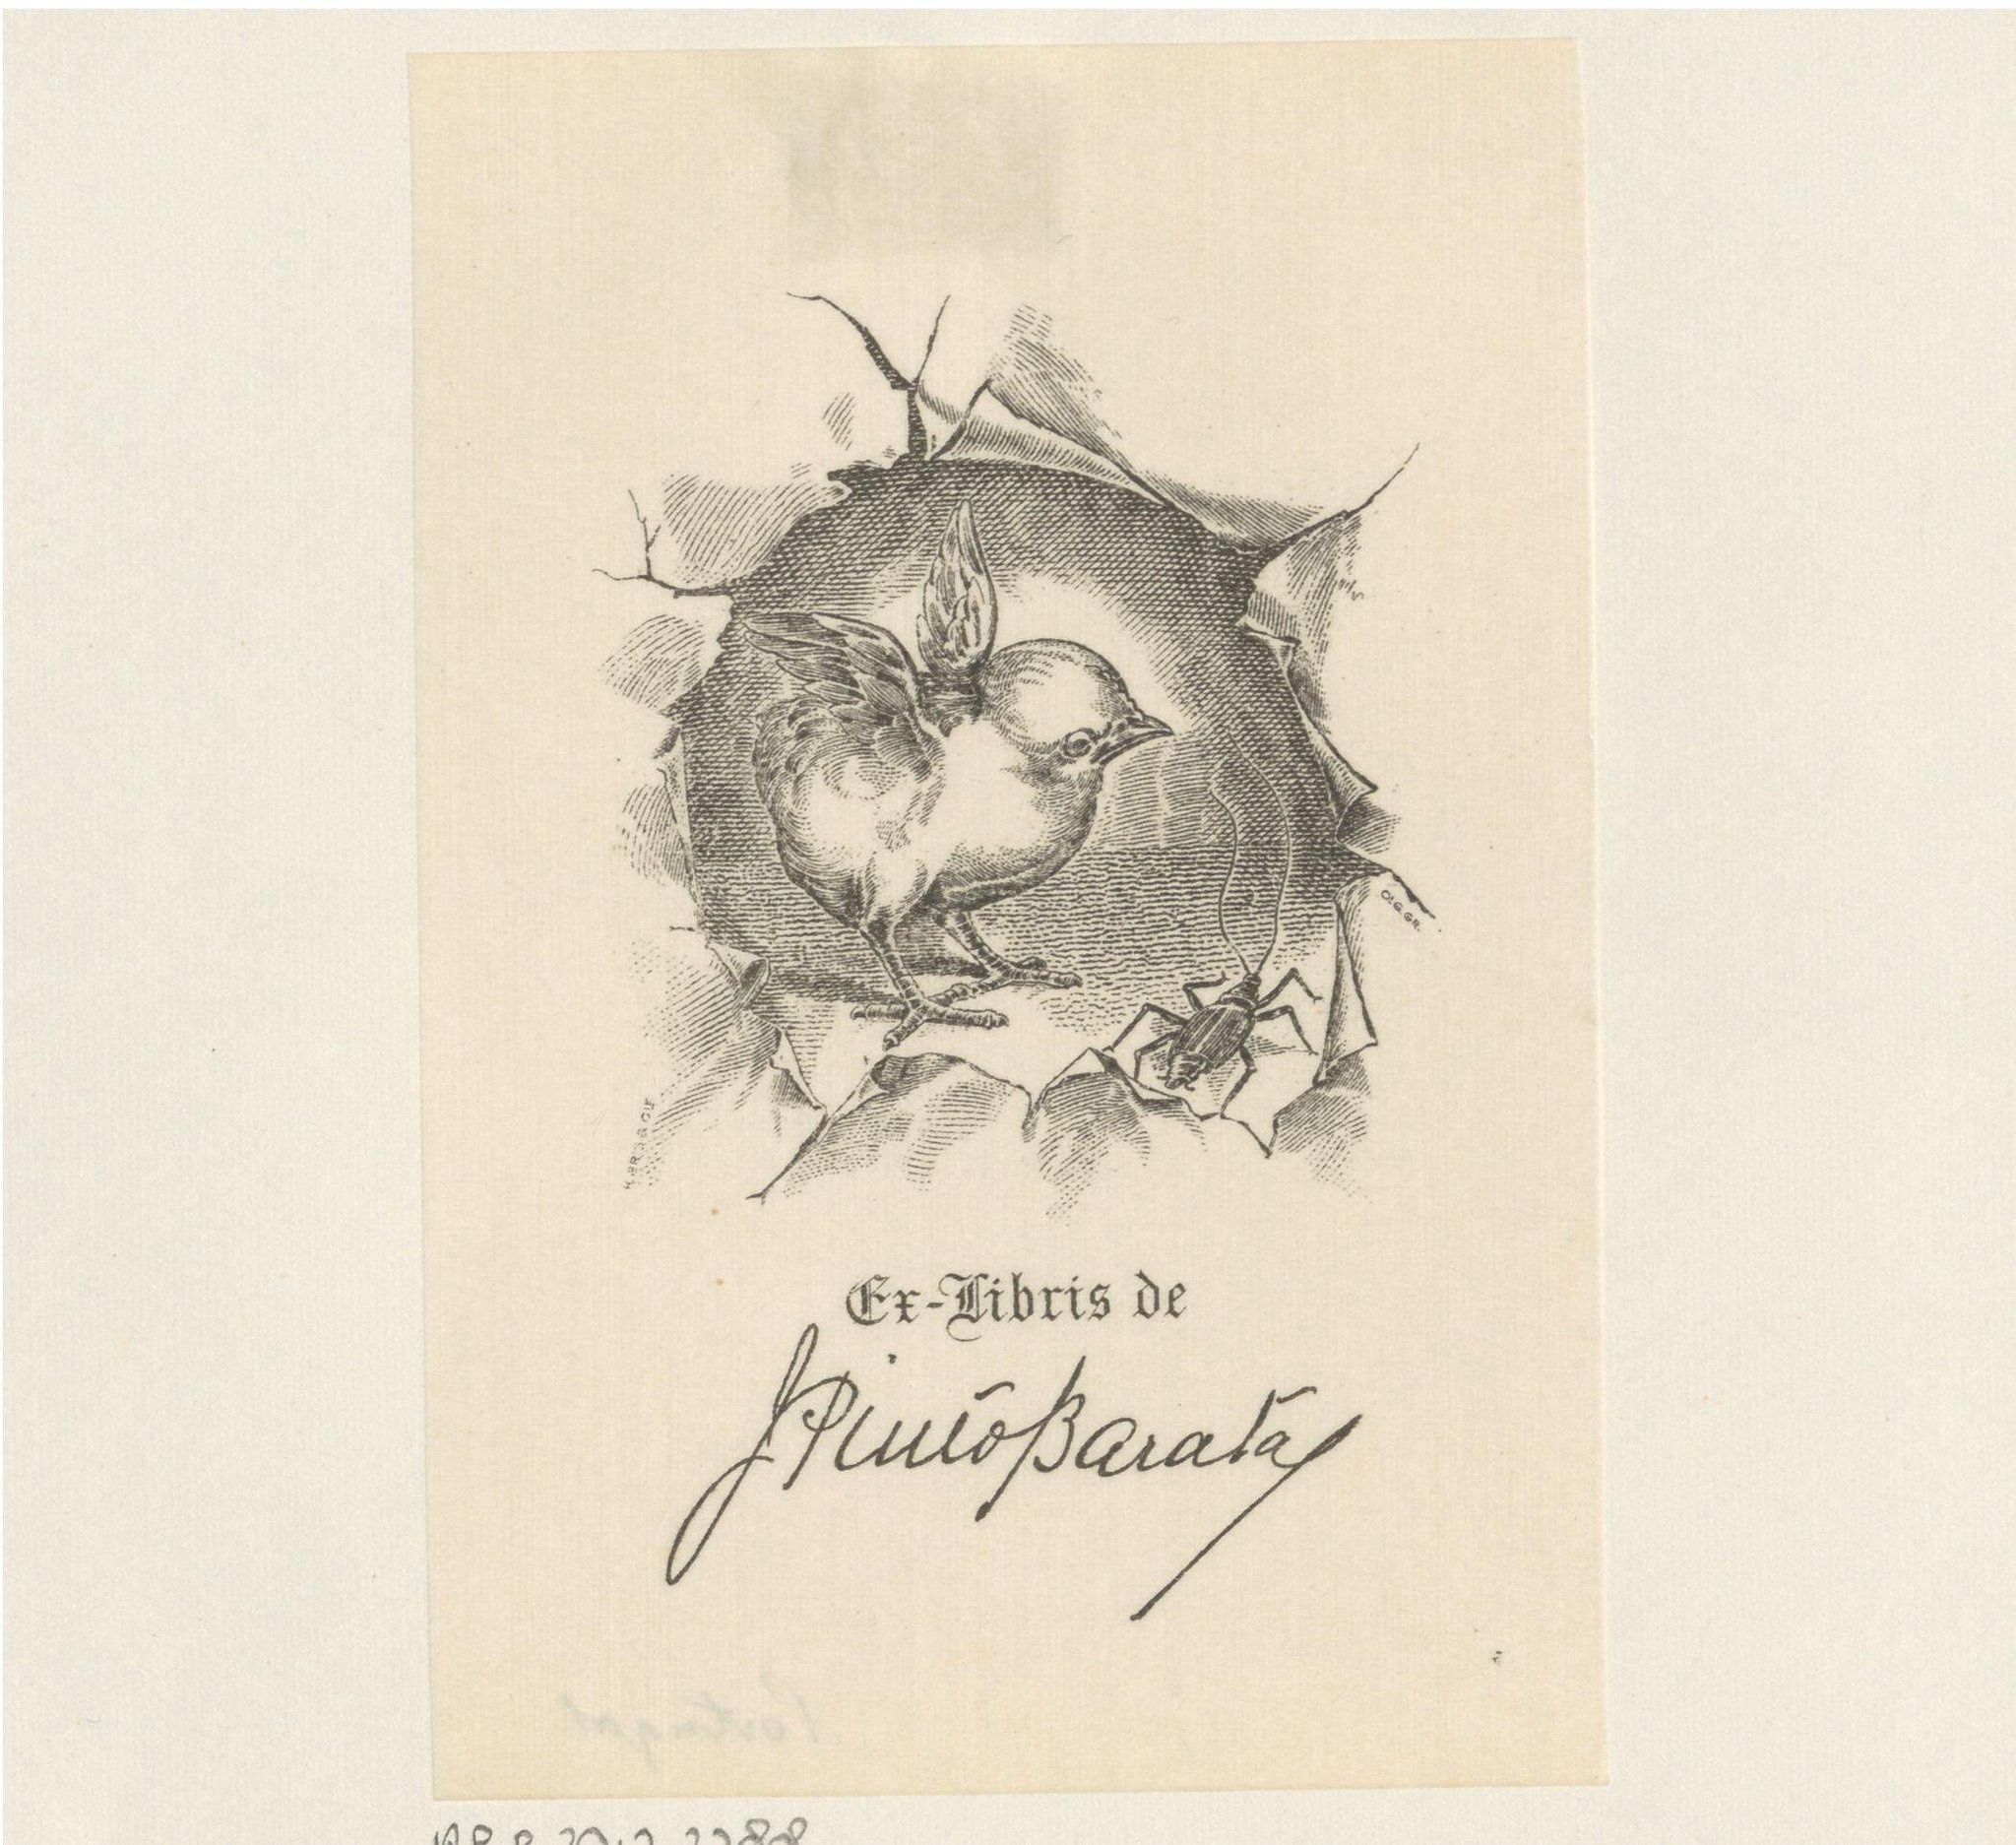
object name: bookplate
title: Ex libris van J. Pinto Baratag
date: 1900-1999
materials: paper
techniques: printing block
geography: portugal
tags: birds, insects: beetle